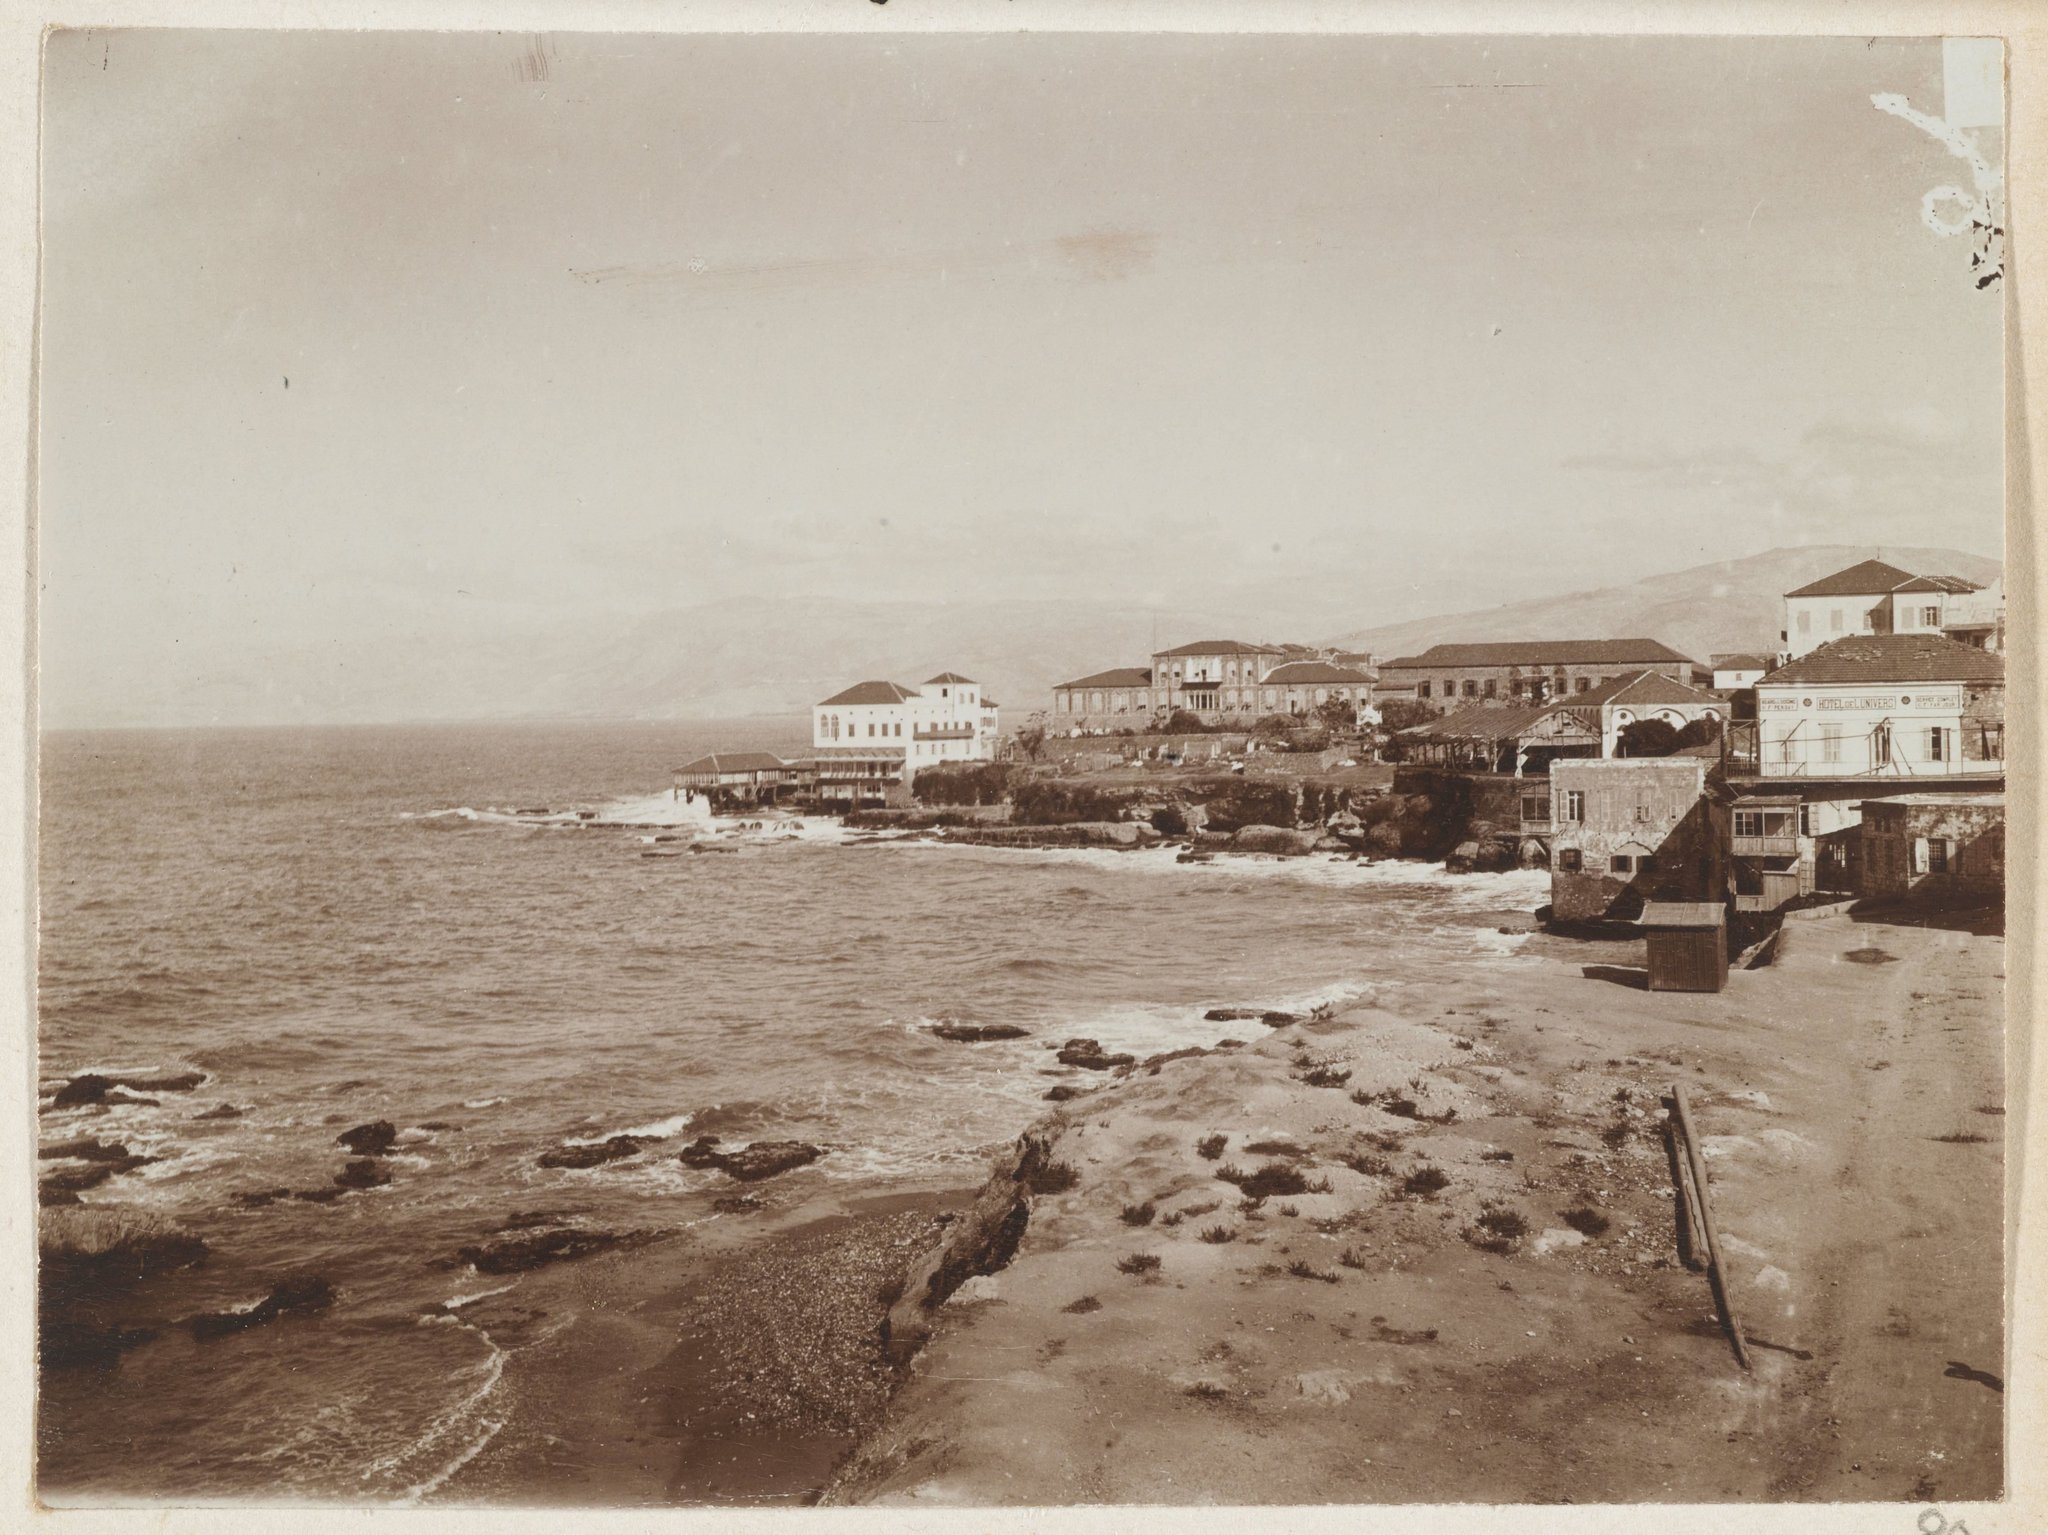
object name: photograph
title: Gezicht op Beiroet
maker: johannes lodewijk heldring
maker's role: fotograaf, predikant, schrijver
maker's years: 1852-1923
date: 1898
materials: paper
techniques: collodion silver print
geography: beirut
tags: city-view in general; 'veduta'